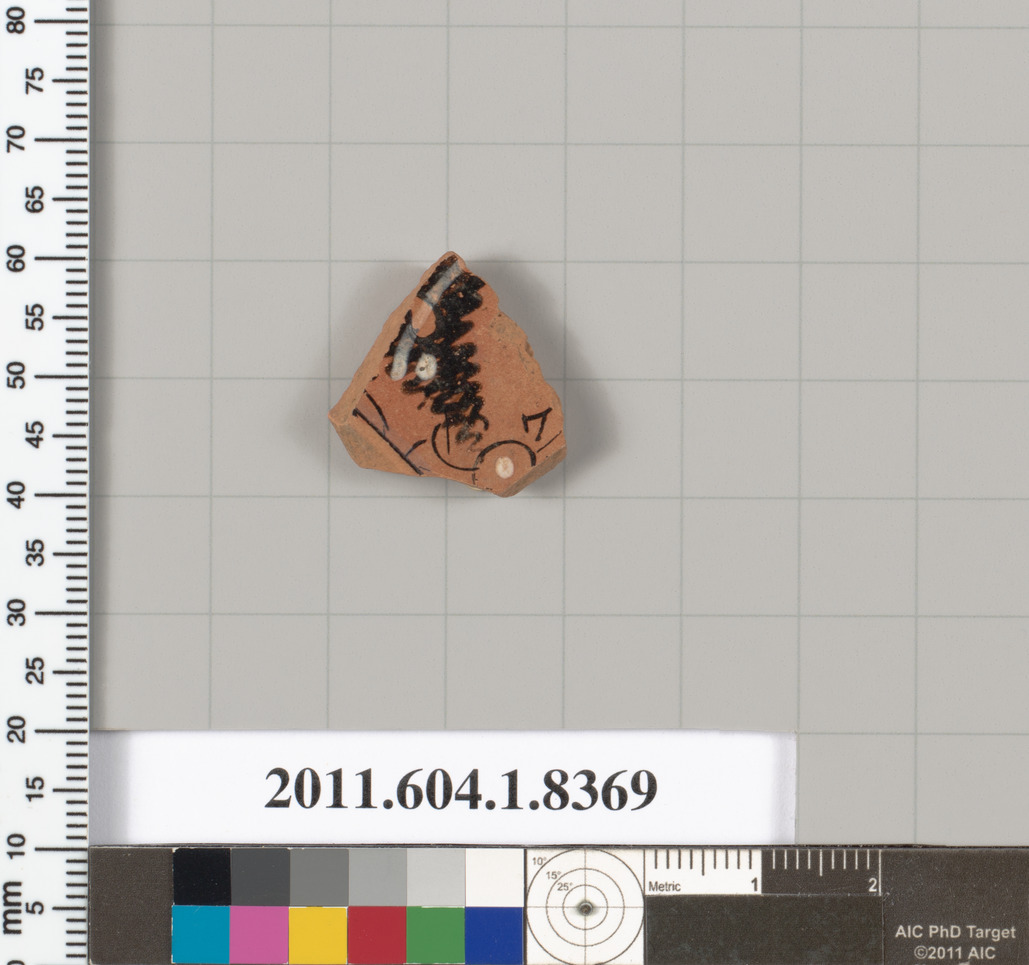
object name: kylix fragment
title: Terracotta fragment of a kylix (drinking cup)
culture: greek, attic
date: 400-376 BCE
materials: terracotta